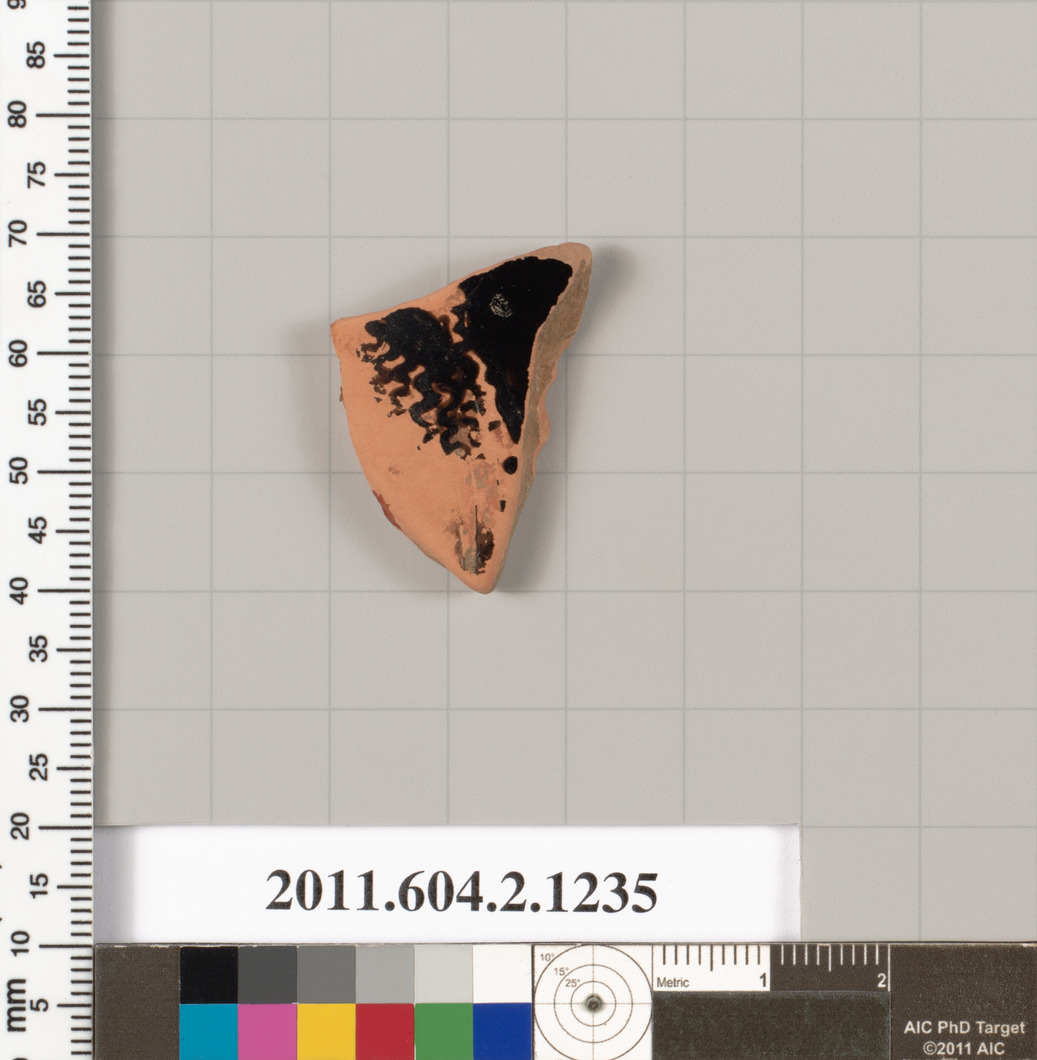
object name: rhyton fragment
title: Terracotta rhyton (vase for libations or drinking)?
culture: greek, attic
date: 475-451 BCE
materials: terracotta